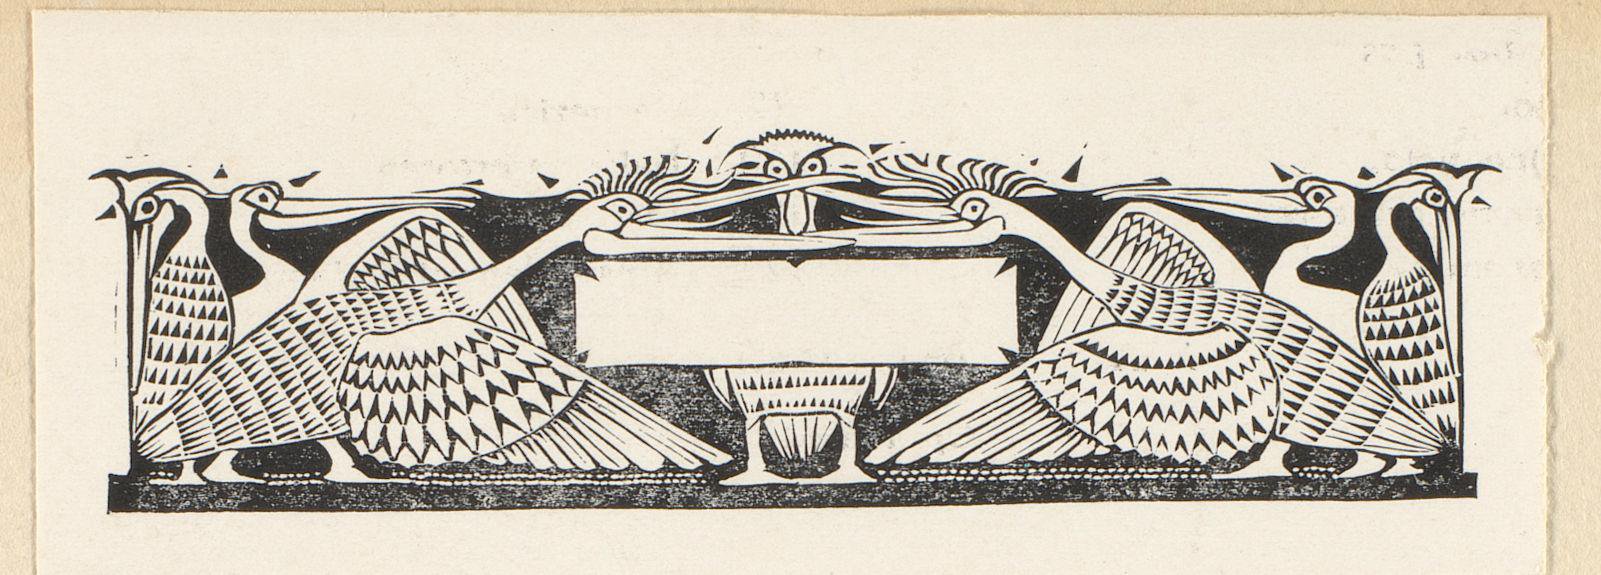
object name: book illustration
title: Titelhoofd met kraanvogels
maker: gerrit willem dijsselhof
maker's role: designer, draughtsman, print maker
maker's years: 1866-1924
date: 1893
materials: paper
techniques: woodcut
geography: haarlem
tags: shore-birds and wading-birds: crane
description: Dit vignet werd oorspronkelijk ontworpen ter decoratie van de inhoudsopgave van: Crane, Walter. Kunst en samenleving. [Vertaald uit het Engels door] Jan Veth. Amsterdam: Scheltema & Holkema's Boekhandel, 1894 [1893]. In die uitgave staat er echter het woord 'Inhoud' waar hier niets staat. Bekend is ook dat de uitgever Scheltema & Holkema de houtsneden voor de eerder genoemde publicatie hergebruikt heeft voor latere uitgaven. Mogelijk is dit een proefdruk voor de tekst, mogelijk is deze variant later gebruikt zonder het woord 'Inhoud'.